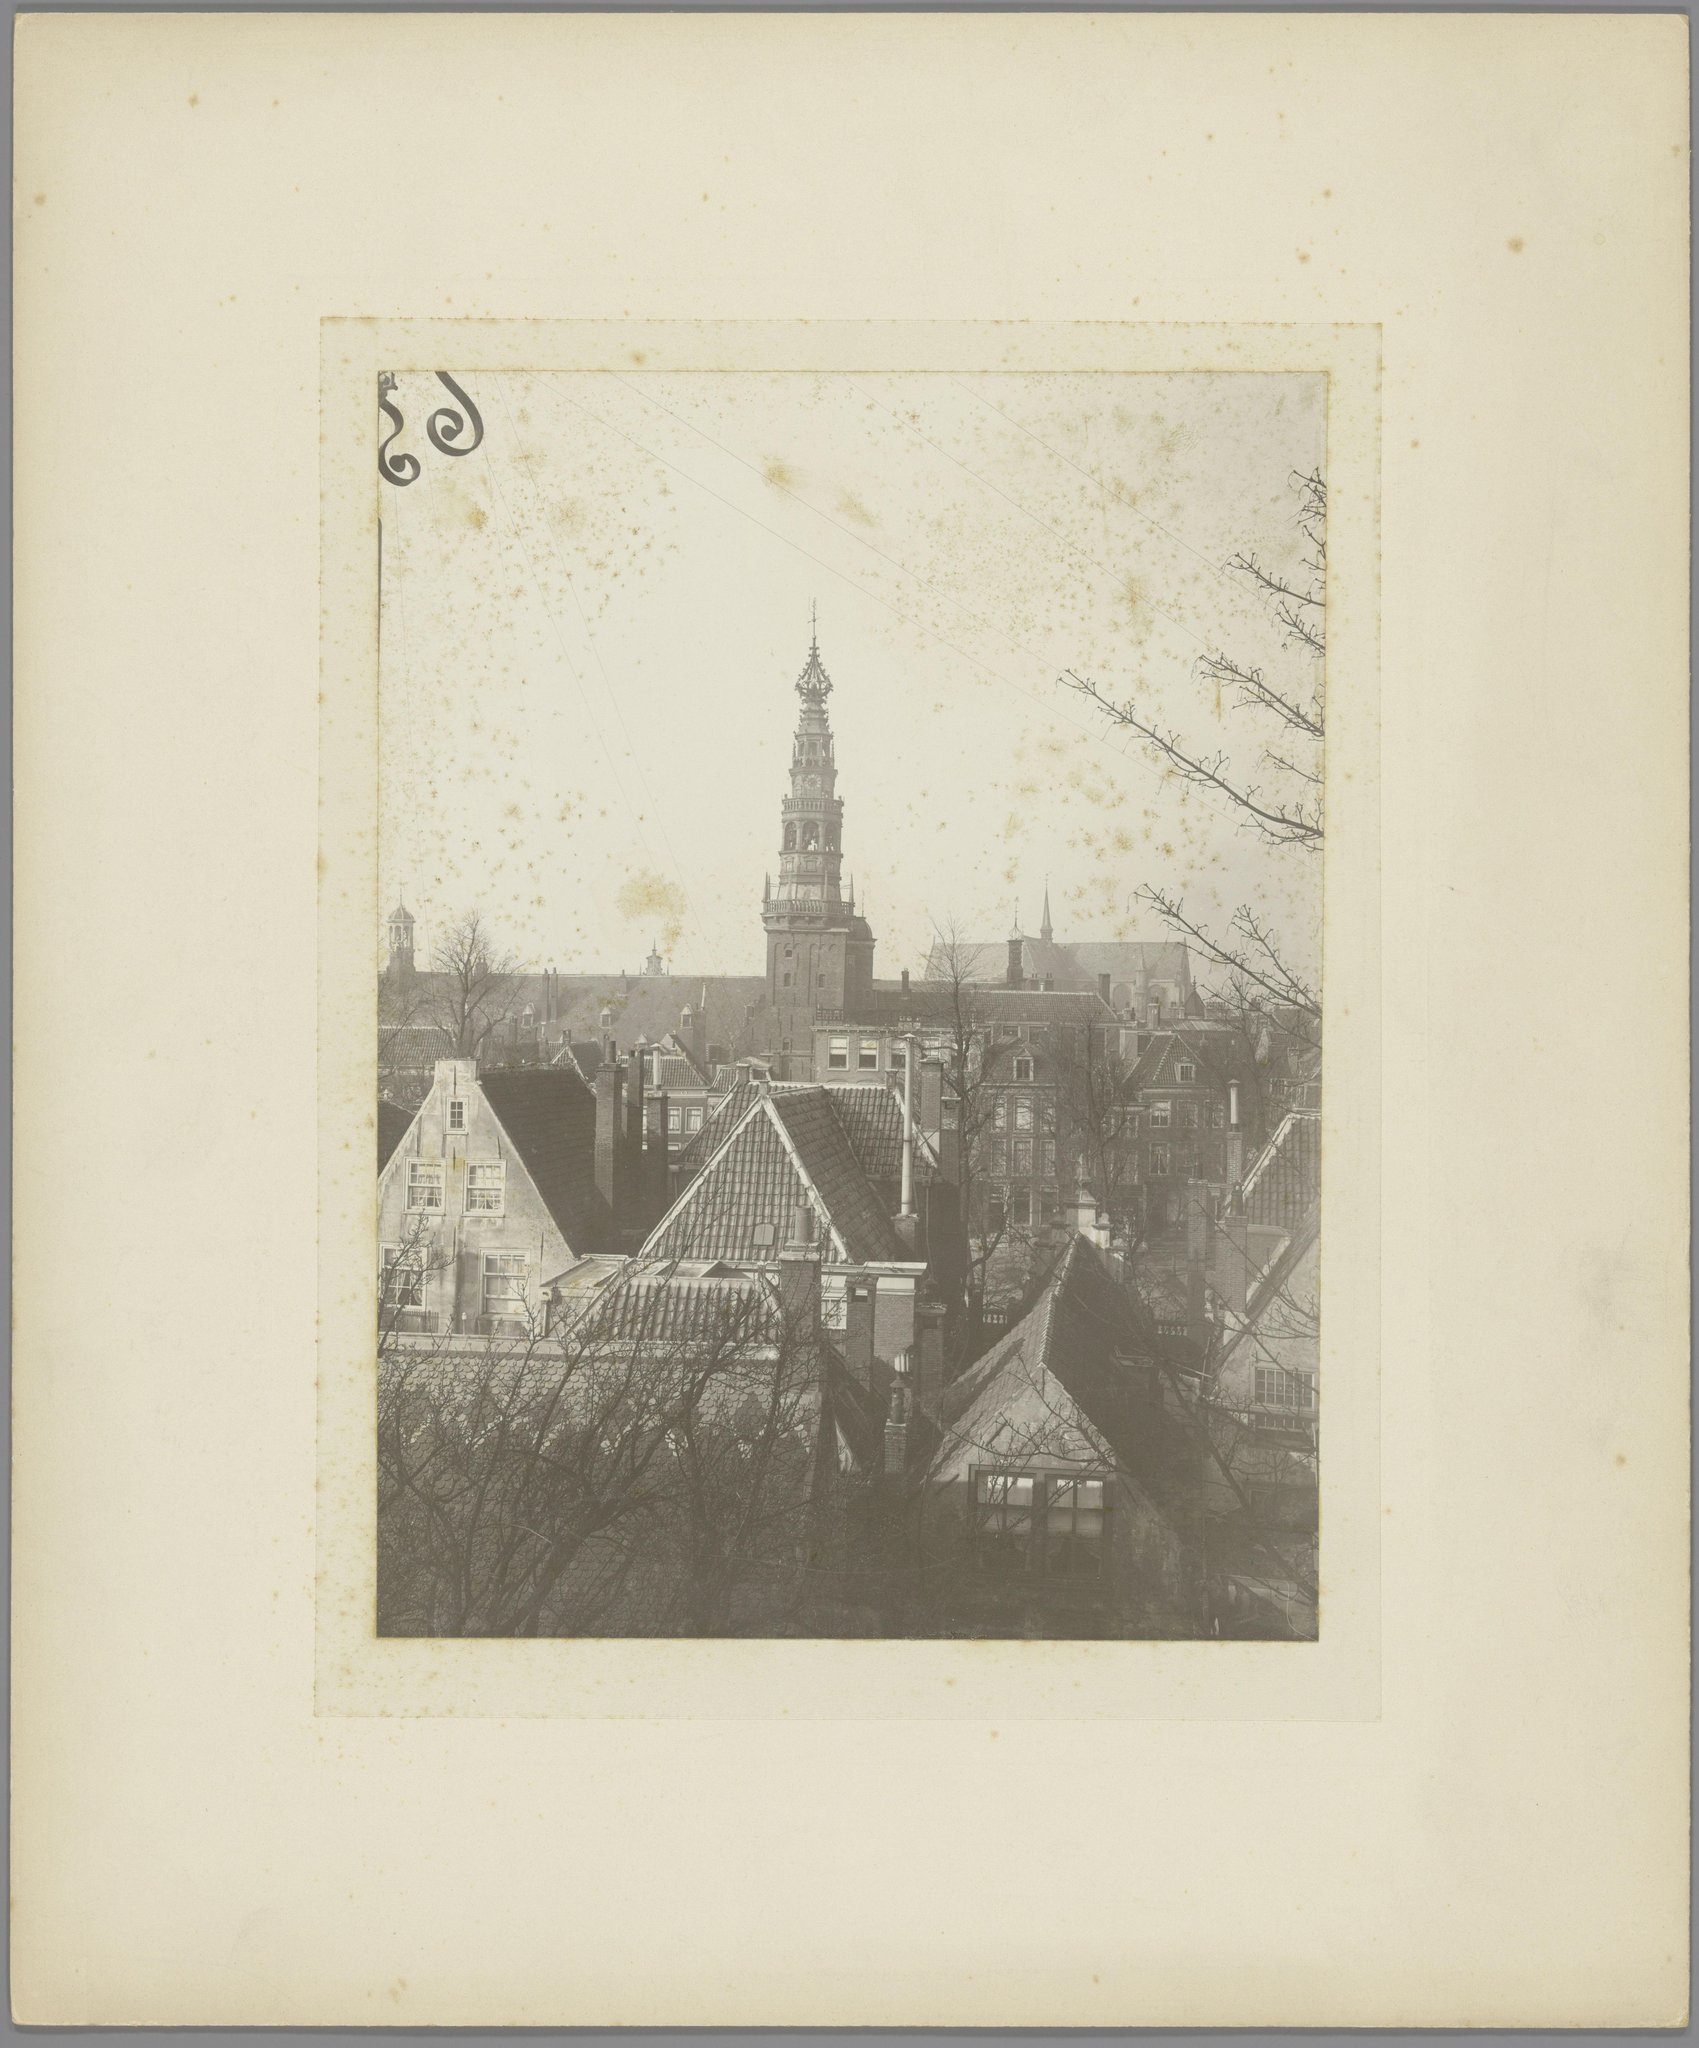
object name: photograph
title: Gezicht op Leiden met het stadhuis en de Pieterskerk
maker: Anonymous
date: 1905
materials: cardboard, photographic support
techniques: collodion silver print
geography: leiden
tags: city-view in general; 'veduta', church (exterior), townhall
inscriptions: annotation: ‘4/19/ 1905?/ Erven J. Veth 1972’